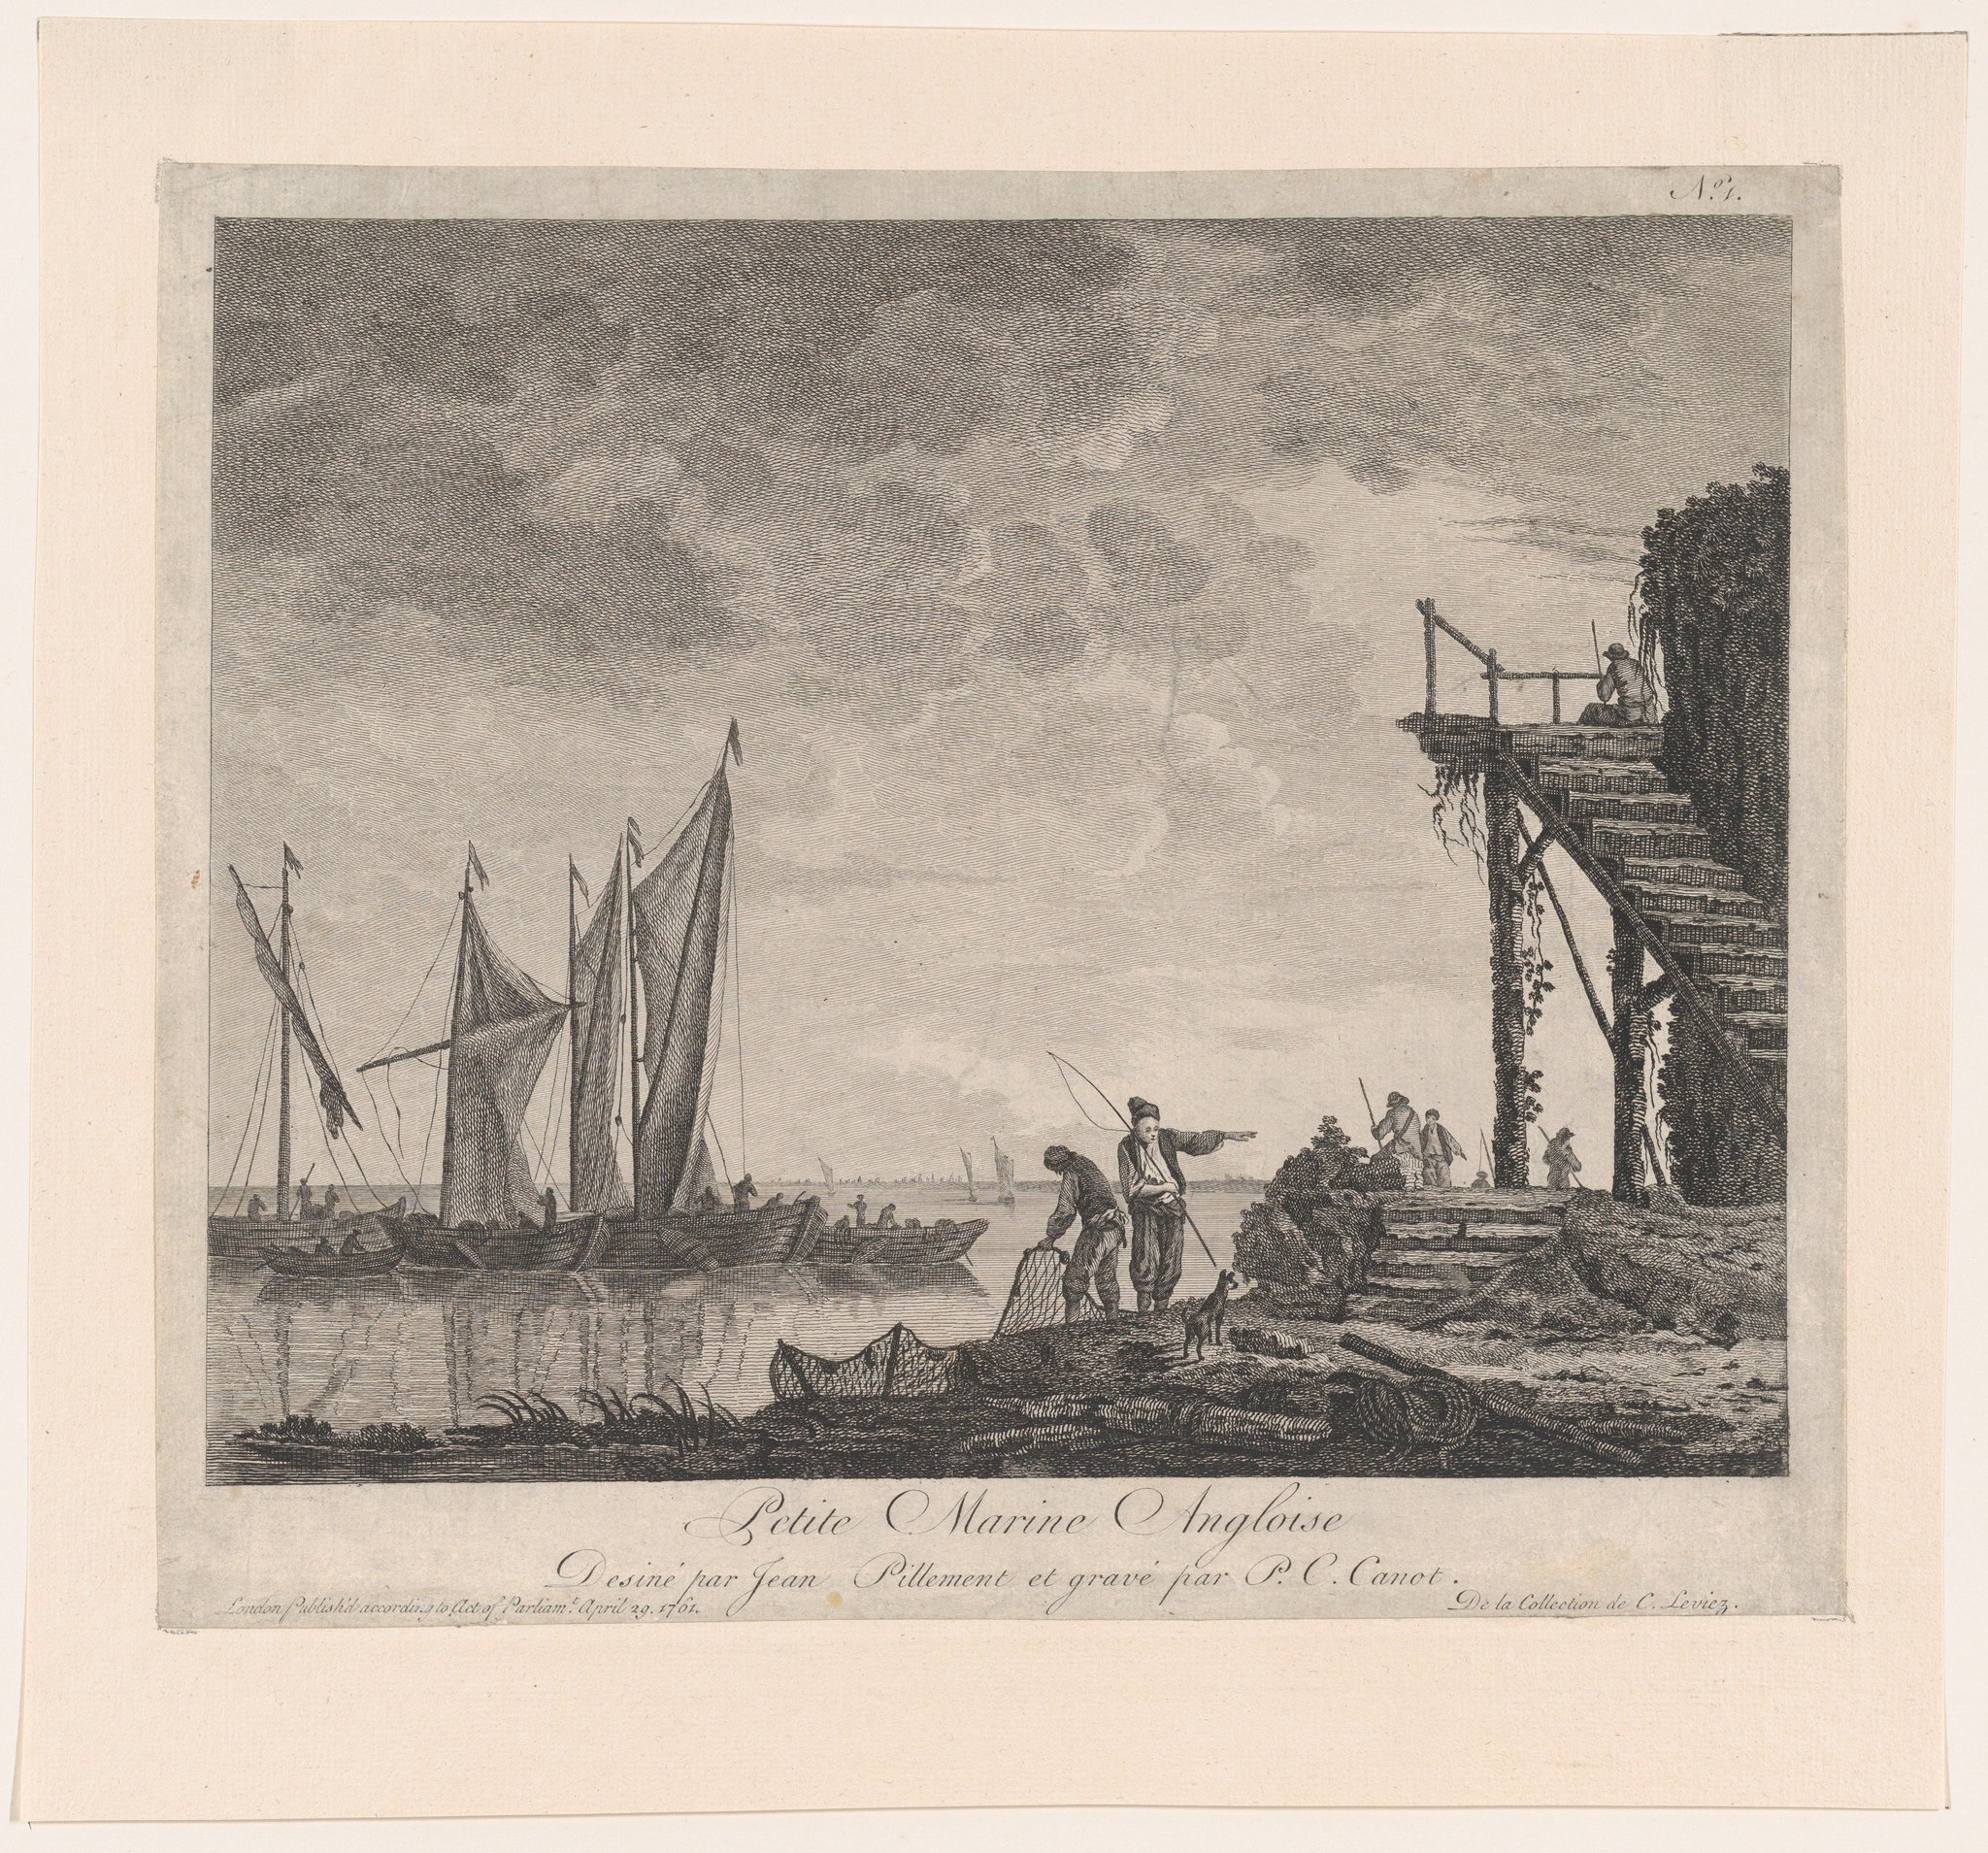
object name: print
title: Petite Marine Angloise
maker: pierre charles canot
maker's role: artist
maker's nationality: french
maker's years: 1710-1777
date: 1761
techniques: etching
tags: men,boats